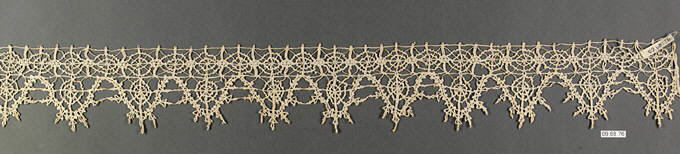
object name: edging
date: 1600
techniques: lace